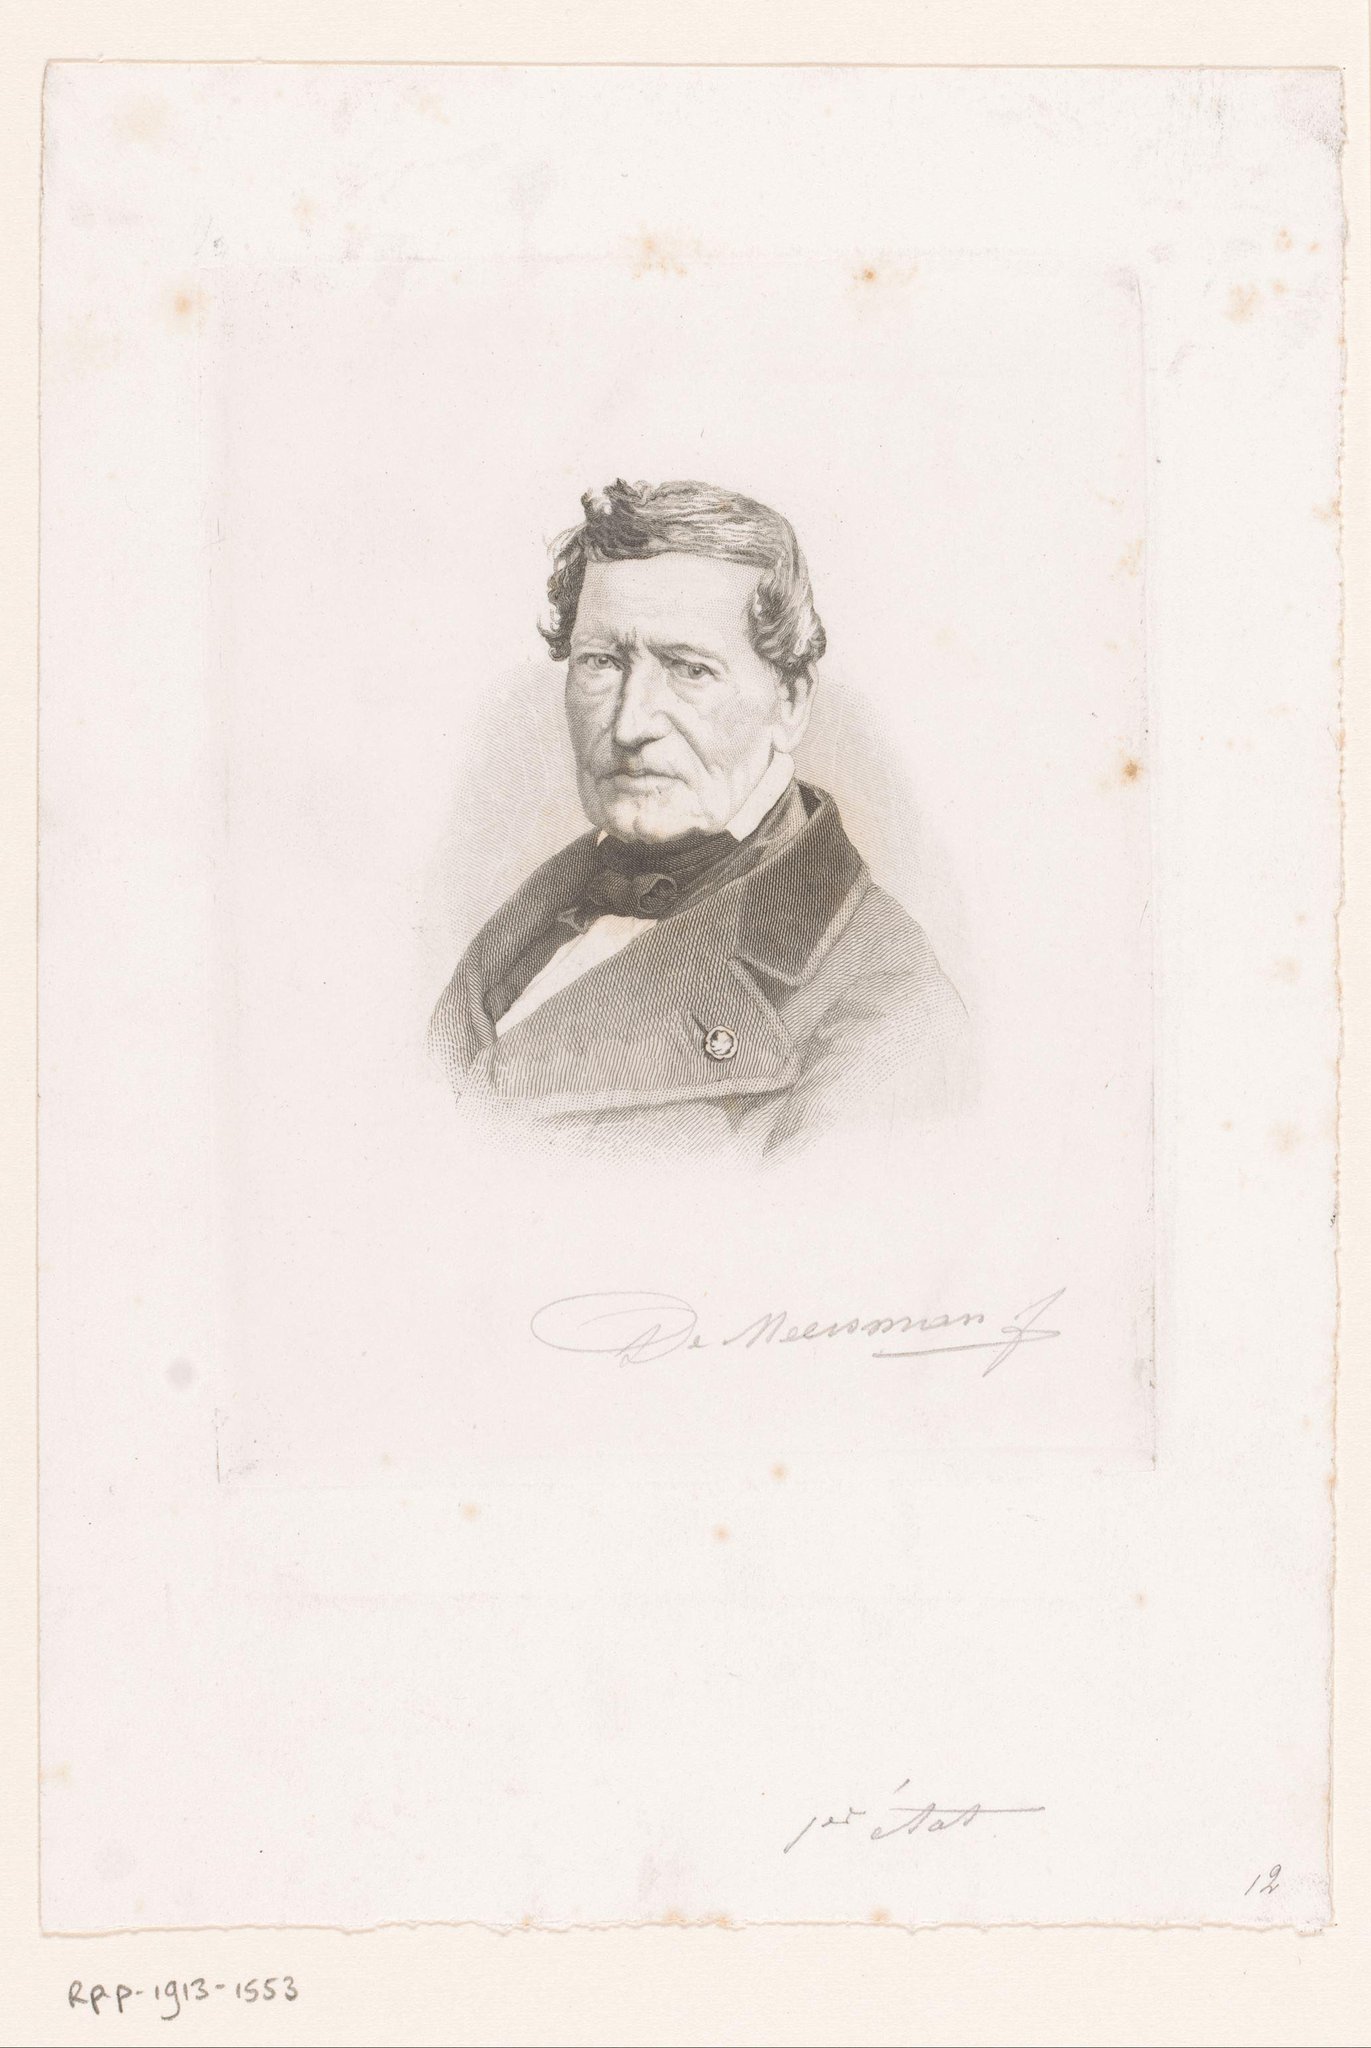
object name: print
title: Portret van een onbekende man, mogelijk Daupoigne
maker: françois de meersman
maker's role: print maker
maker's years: 1830-1905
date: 1840-1905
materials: paper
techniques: engraving, etching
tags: adult man, historical persons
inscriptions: inscription: ‘1e état’, collector's mark: Lugt 2228